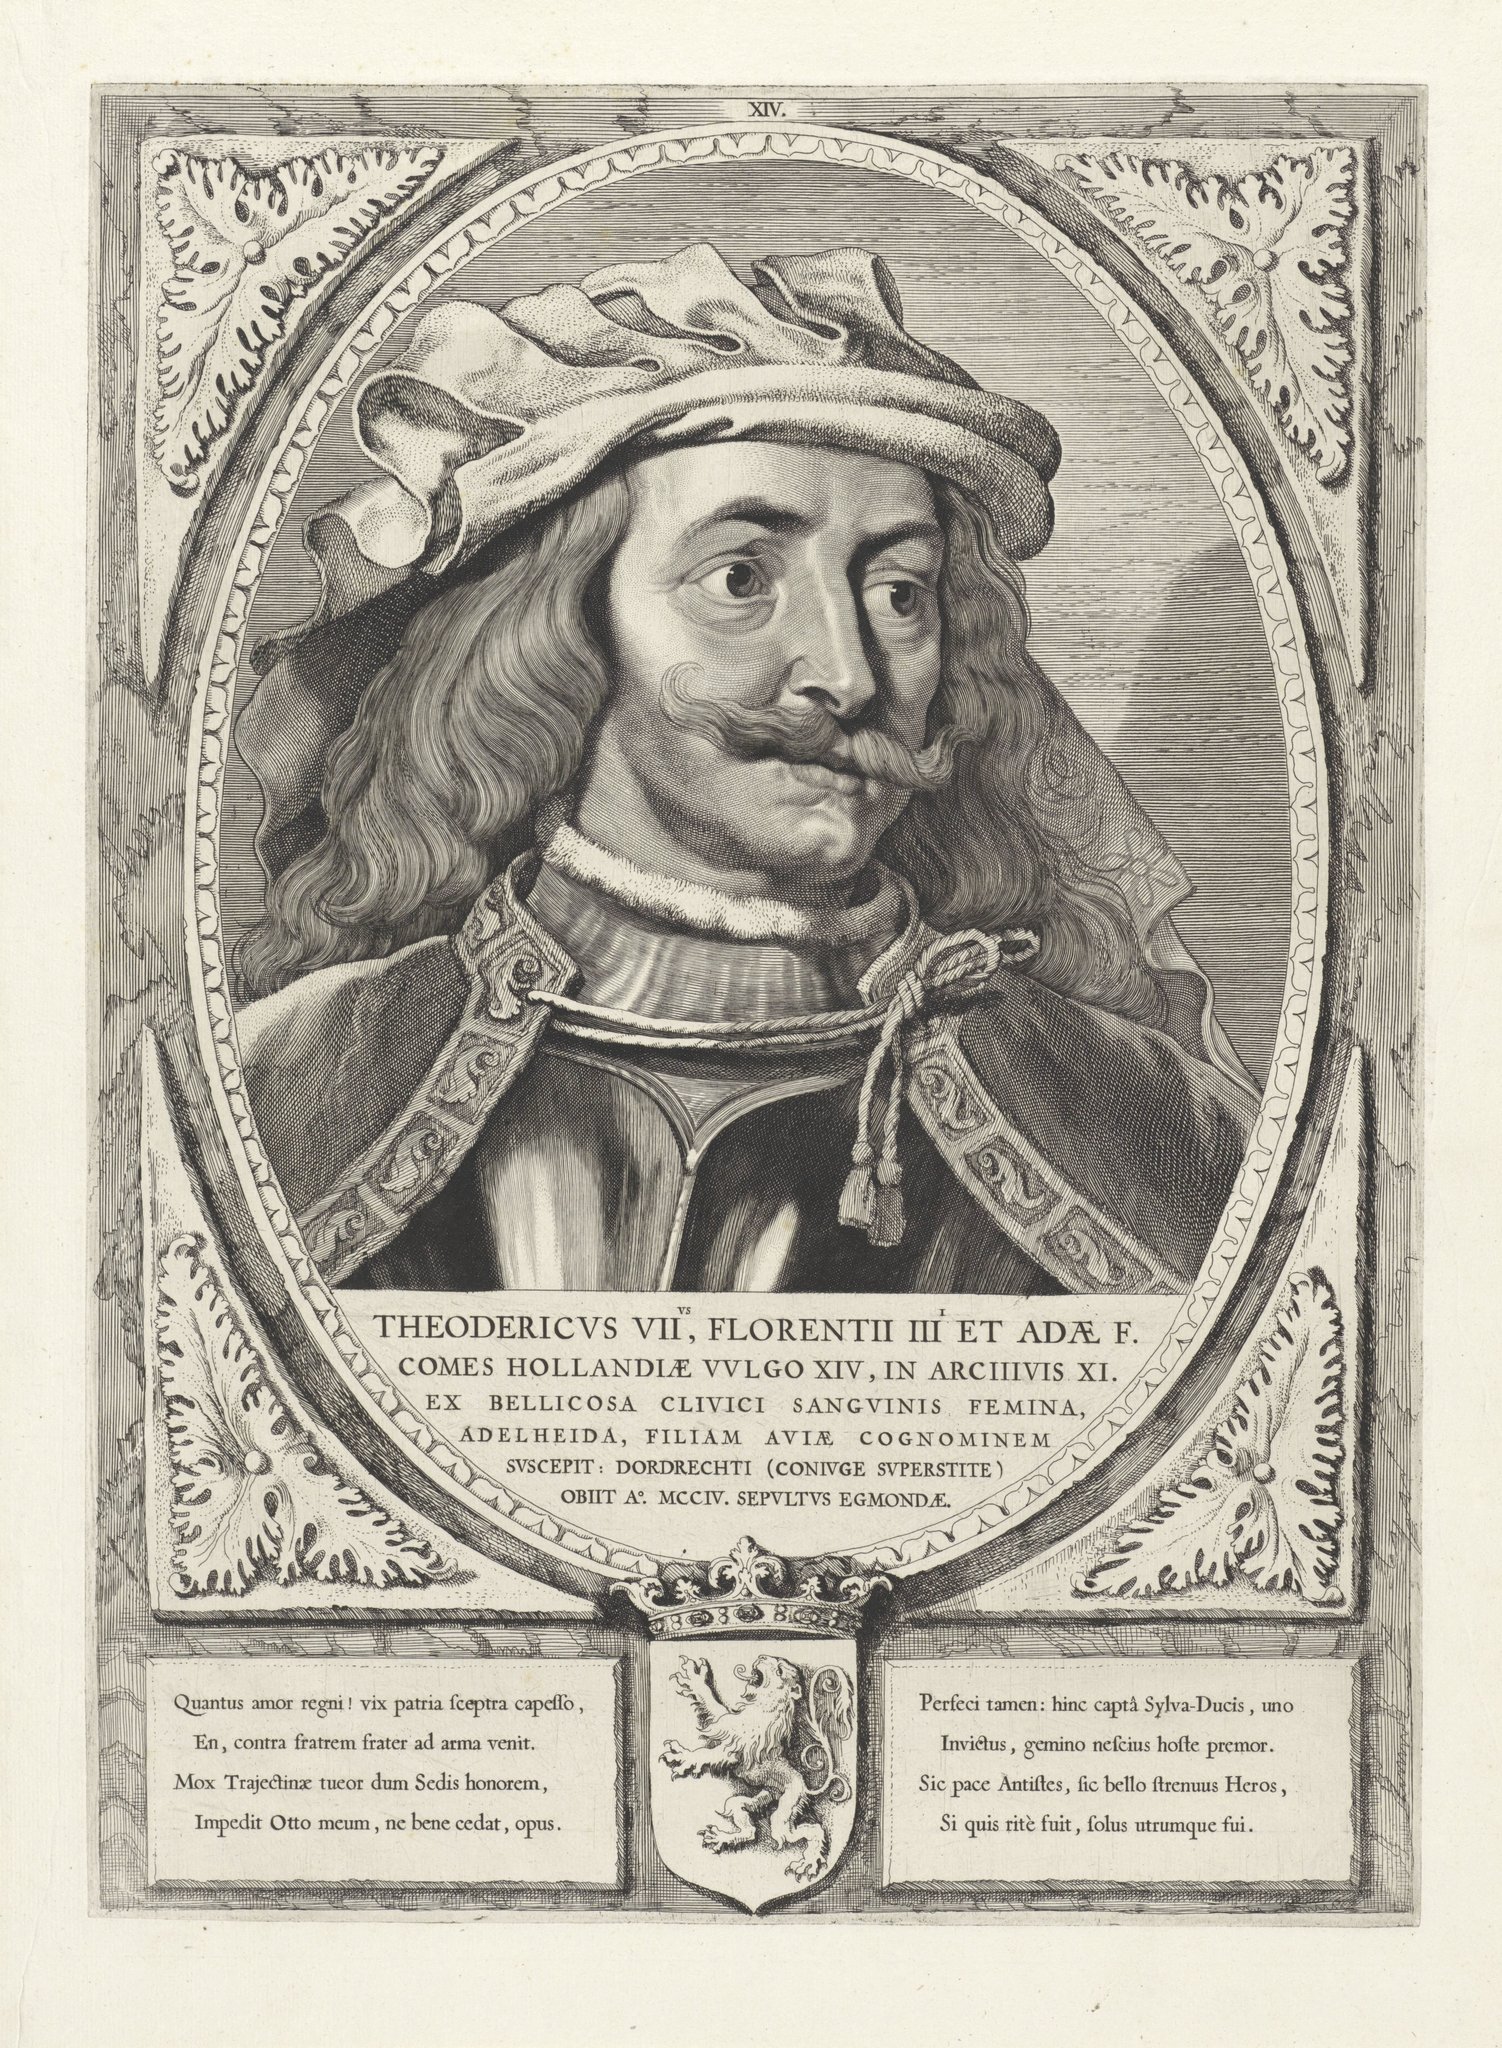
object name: print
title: Portret van Dirk VII, graaf van Holland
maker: cornelis visscher (ii)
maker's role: draughtsman, painter, print maker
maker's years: 1628-1658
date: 1650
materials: paper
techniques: engraving, etching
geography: haarlem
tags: dordrecht, head-gear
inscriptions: collector's mark: Lugt 12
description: Proefdruk van de veertiende prent uit de serie 'Graven en gravinnen van Holland, Zeeland en West-Friesland', bestaande uit 38 prenten.